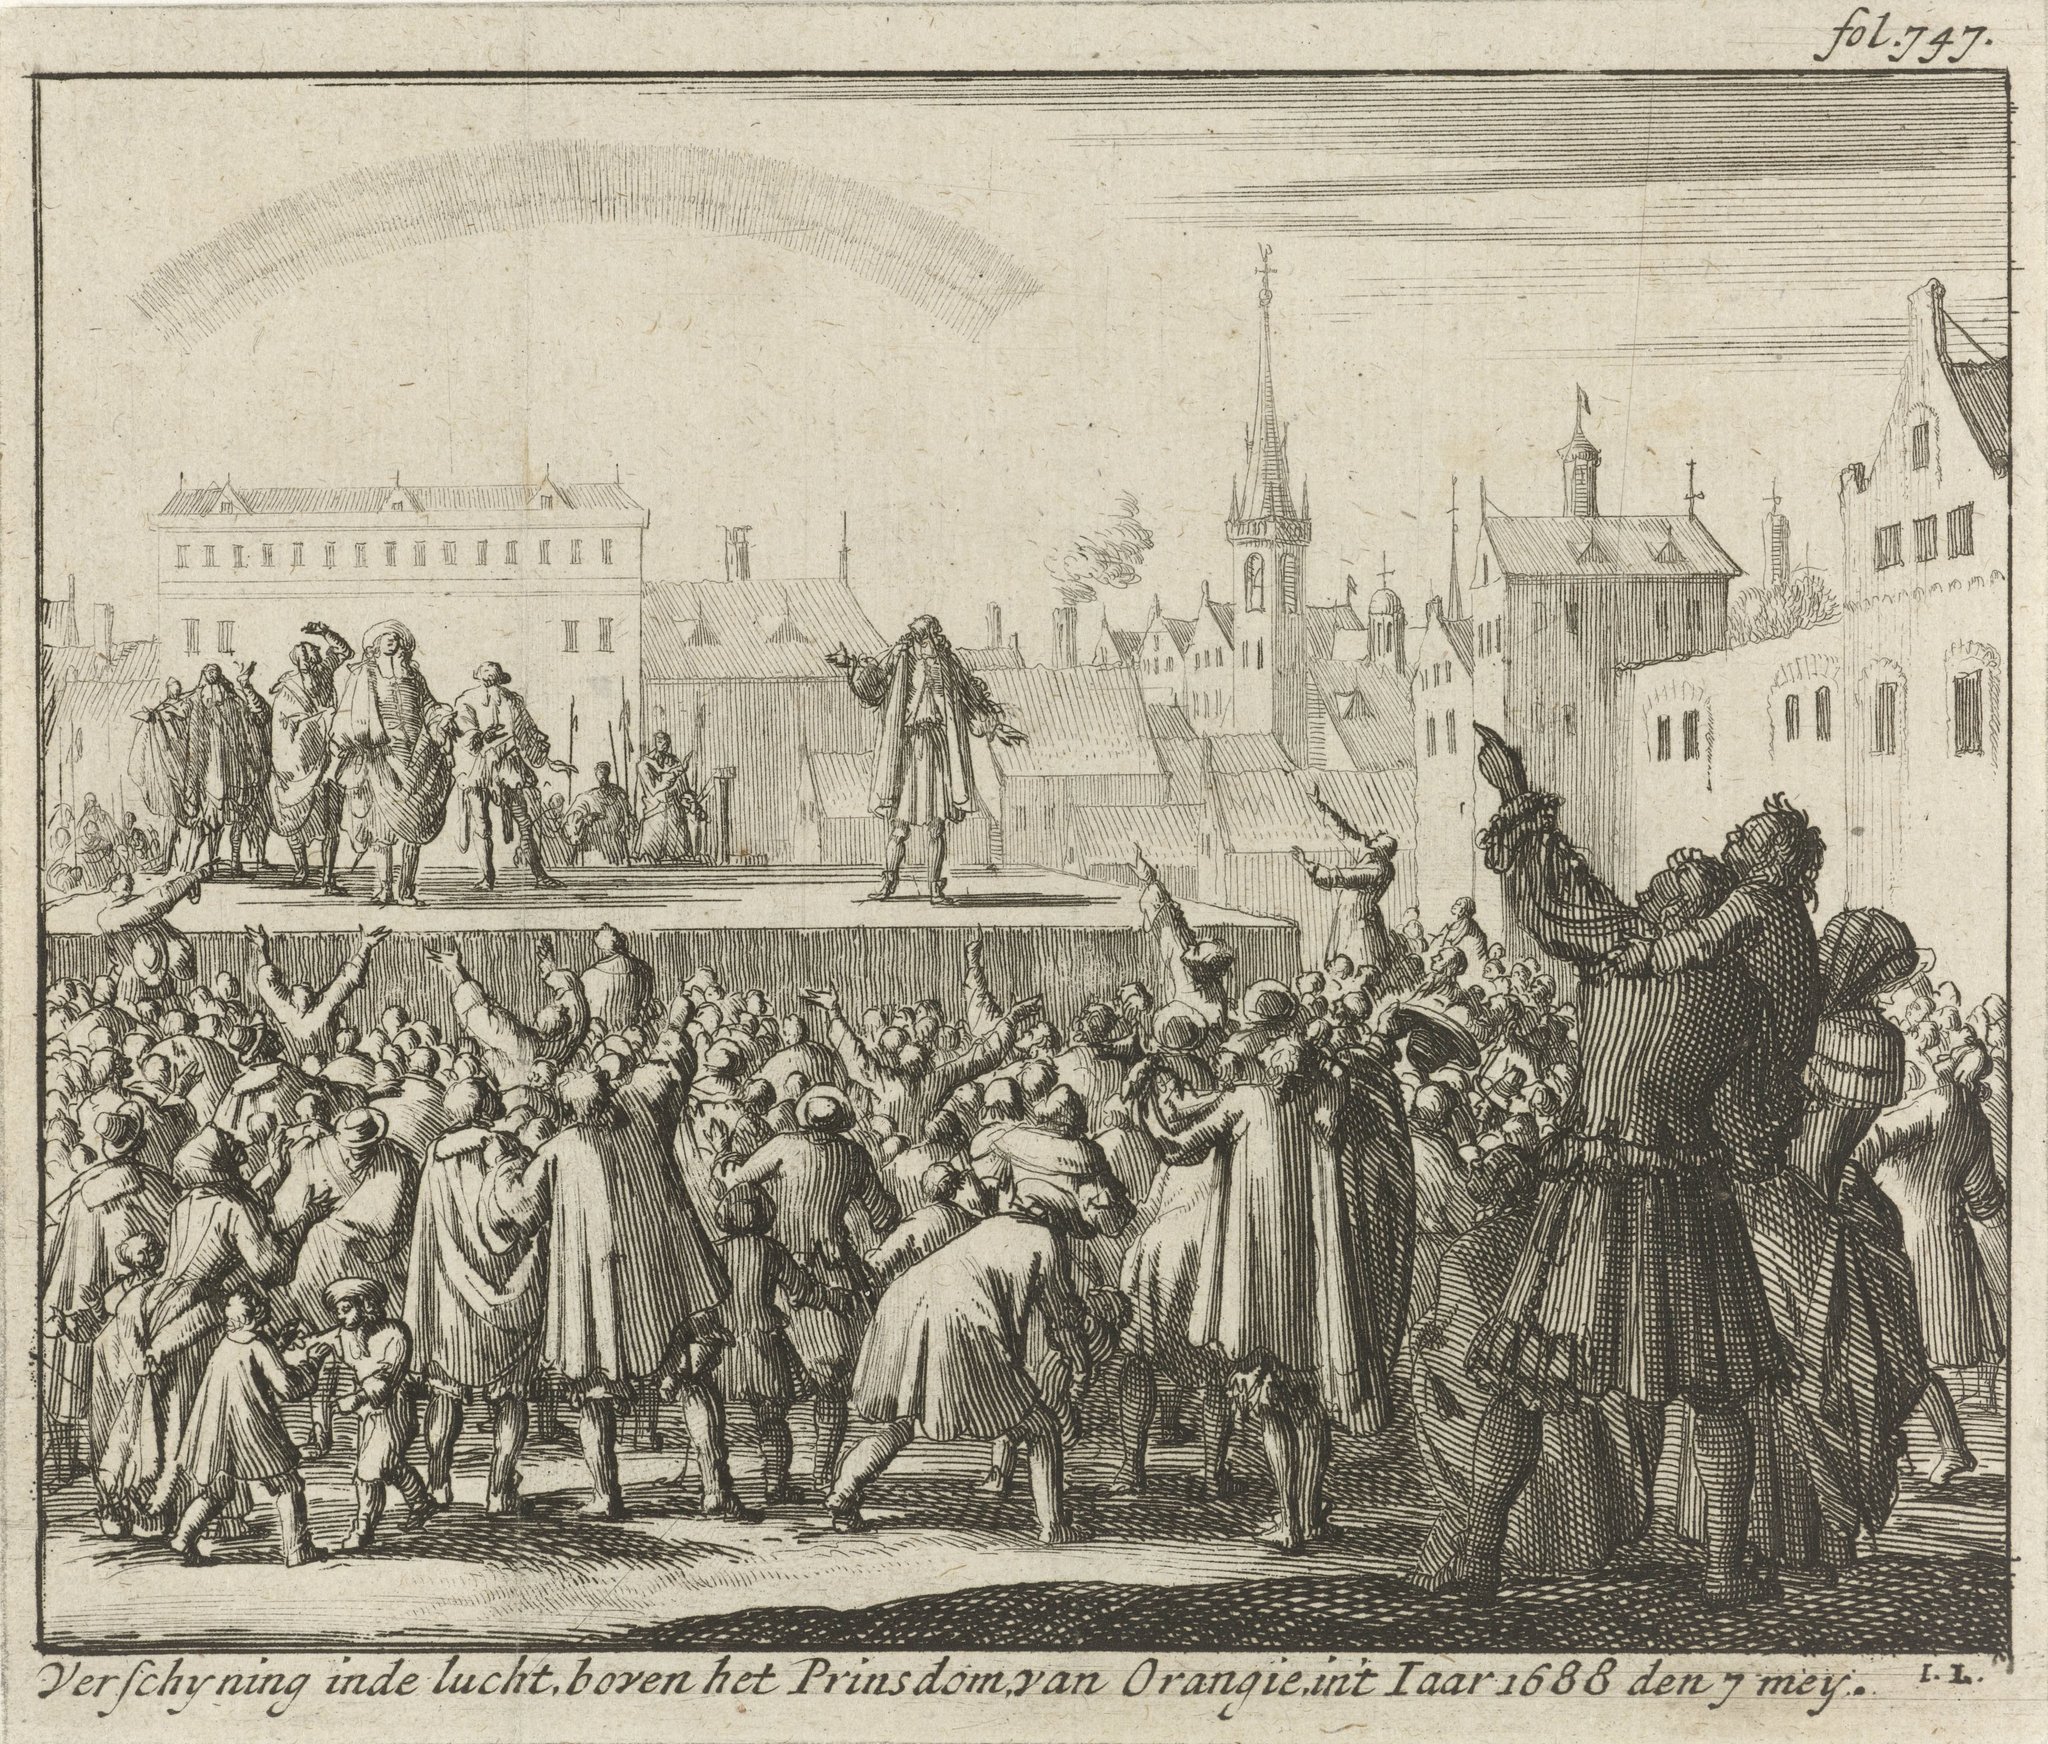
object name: print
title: Eed van trouw afgelegd door het vorstendom Orange aan prins Willem III, 1665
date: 1689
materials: paper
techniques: etching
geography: amsterdam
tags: constantijn huygens (i), the hague, william iii (prince of orange and king of england, scotland, and ireland), nimbus, halo ~ radiance emanating from persons or things, swearing allegiance to a ruler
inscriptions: collector's mark: Lugt 2228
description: Eed van trouw afgelegd door de steden en de ingezetenen van het vorstendom van Orange aan prins Willem III, 7 mei 1665 (hier ten onrechte geplaatst in het jaar 1688). Ceremonie met de afgevaardigden van de prins en van Orange zittend op een podium opgesteld op een plein te Orange, voor het podium een grote menigte toeschouwers. In de lucht het wonderbaarlijke verschijnsel van een kroon van zonlicht. Prent rechtsboven gemerkt: fol. 747.